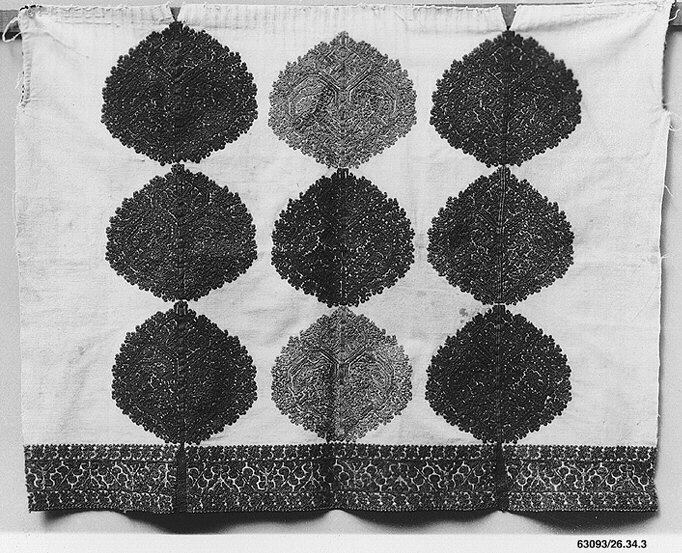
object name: sleeve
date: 1801-1900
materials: linen, silk